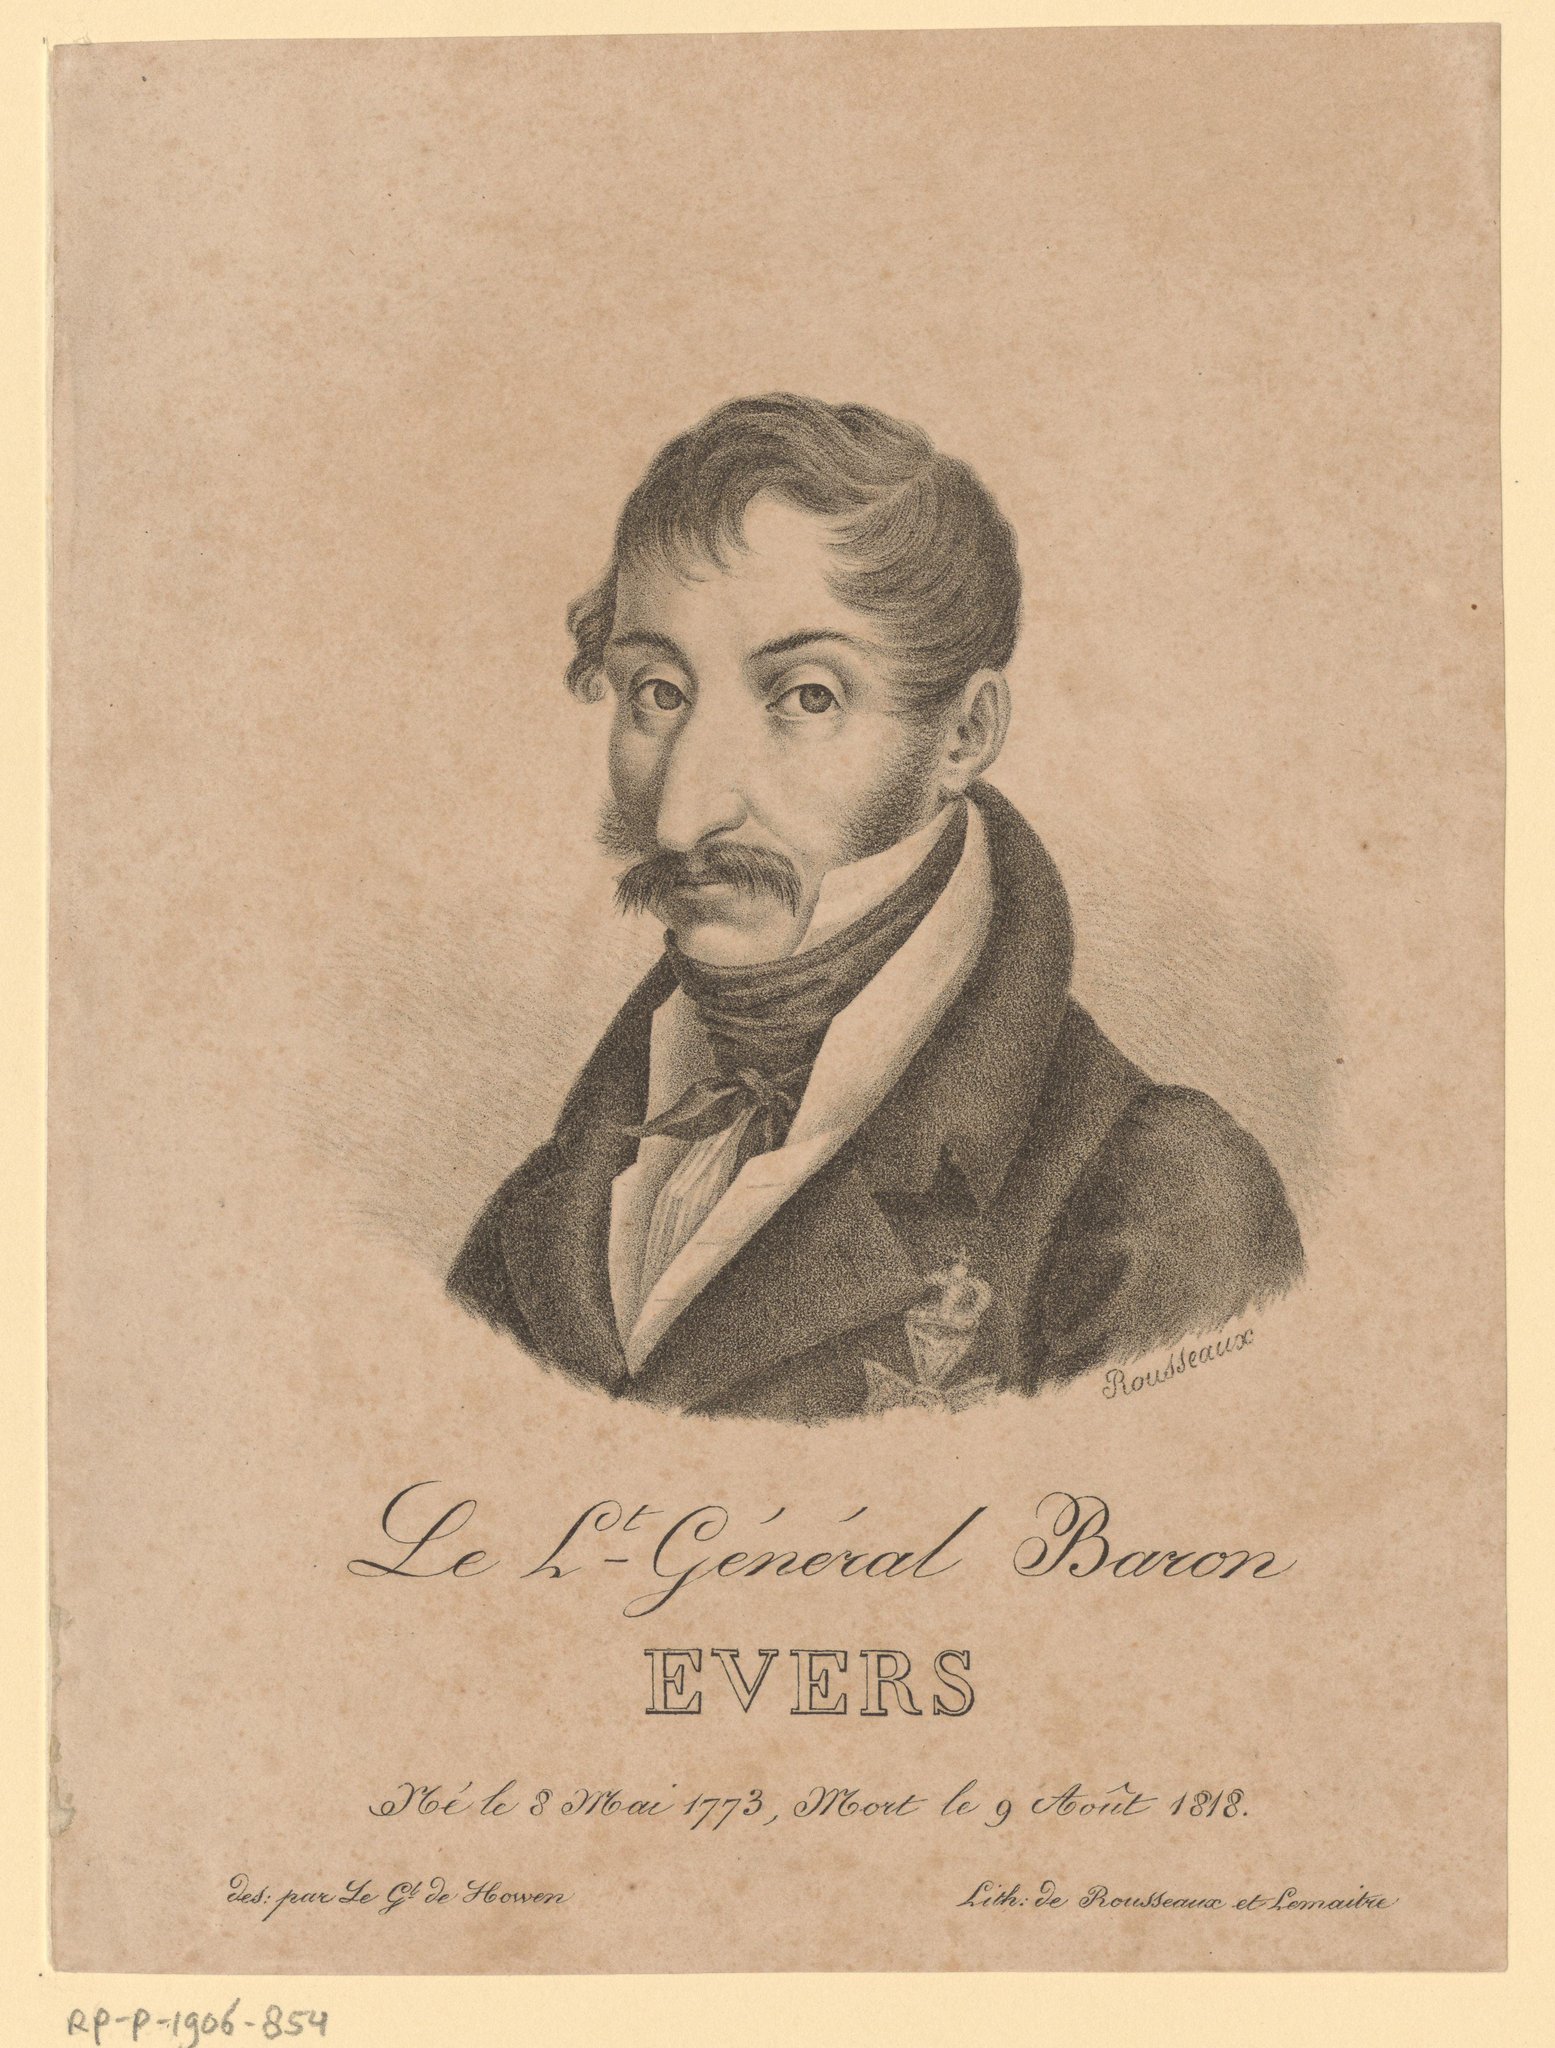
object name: print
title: Portret van Carel Joseph Evers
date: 1818-1833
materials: paper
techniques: lithograph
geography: namur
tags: brussels, historical persons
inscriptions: collector's mark: Lugt 2228